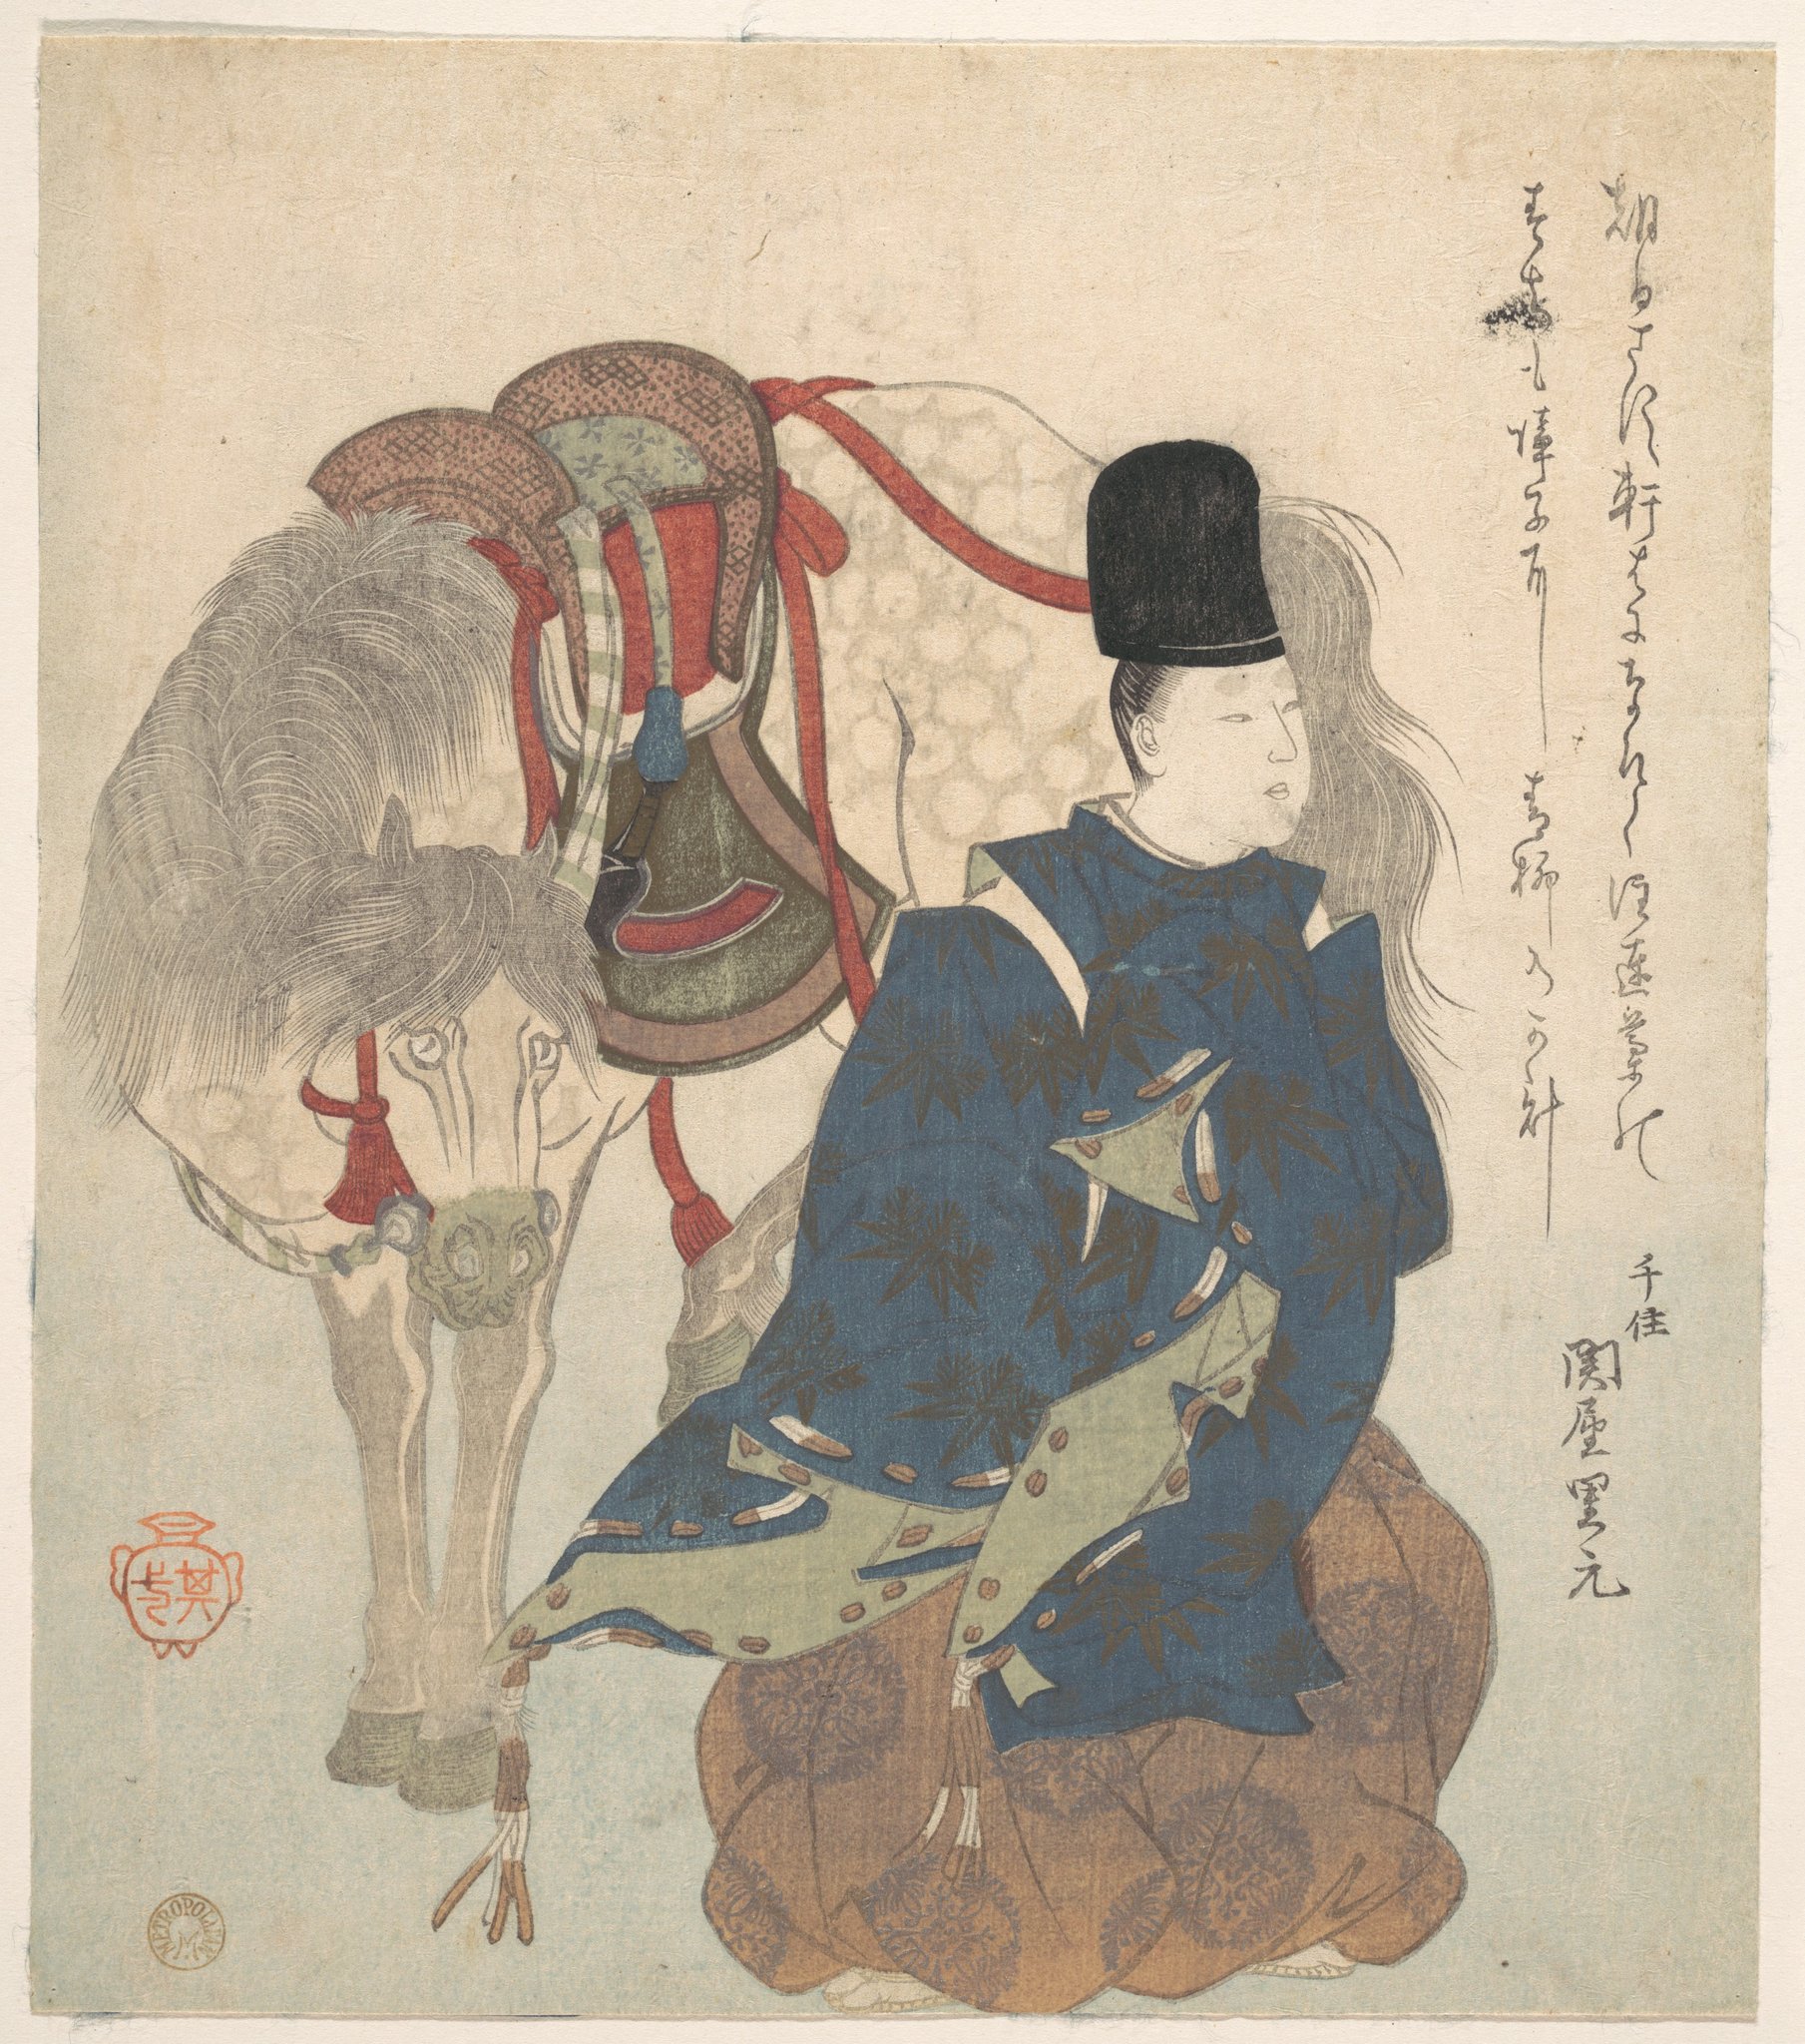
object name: woodblock print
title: Young Nobleman Crouching beside His Horse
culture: japanese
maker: suzuki kiitsu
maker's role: artist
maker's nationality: japanese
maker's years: 1796-1858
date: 1798-1810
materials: ink, paper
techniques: surimono, woodblock print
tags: men,horses